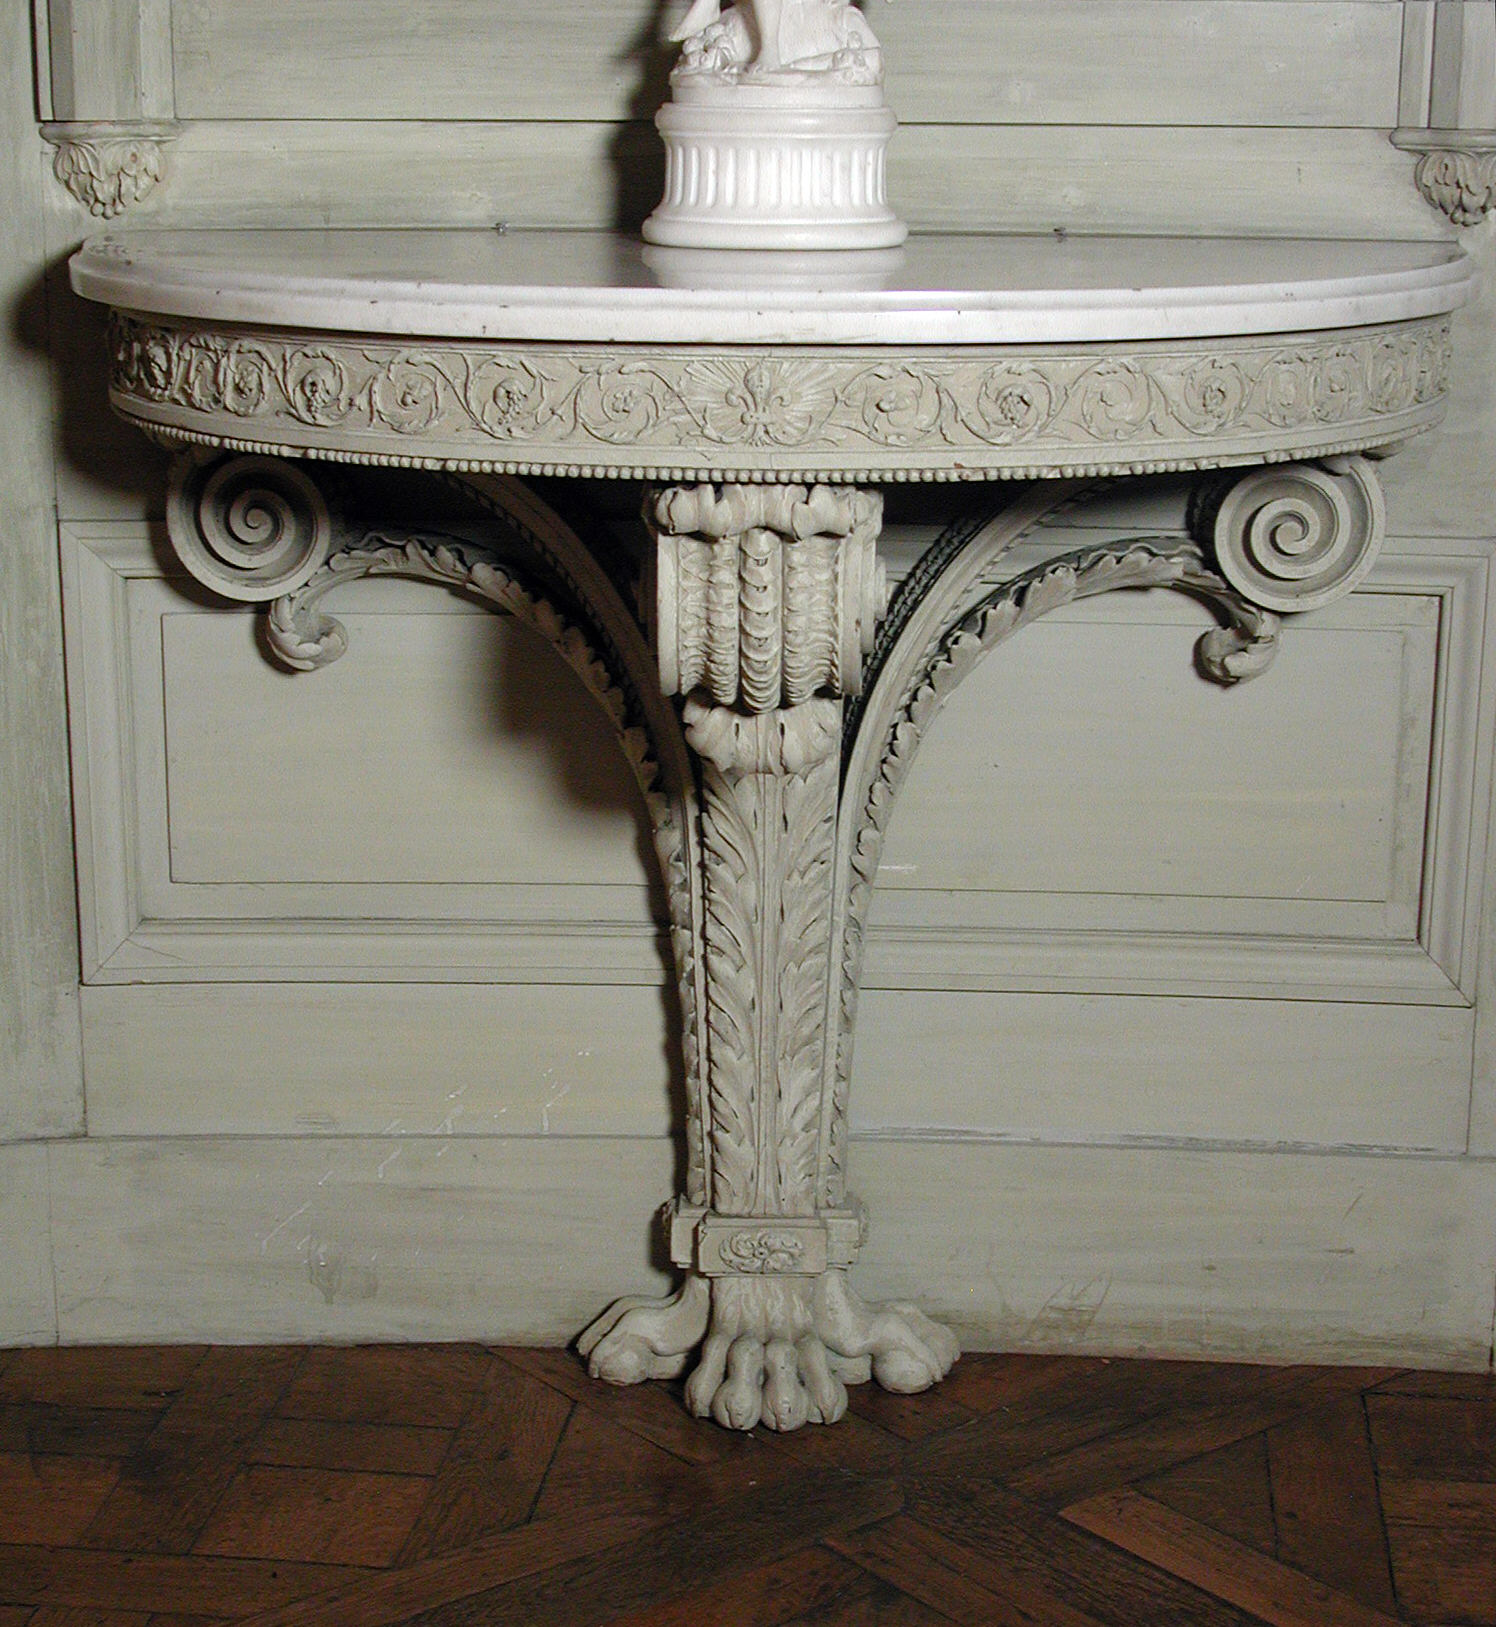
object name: console table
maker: richard de lalonde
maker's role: designer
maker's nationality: french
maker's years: 1780-1790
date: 1780-1790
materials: marble, wood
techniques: carving, painting